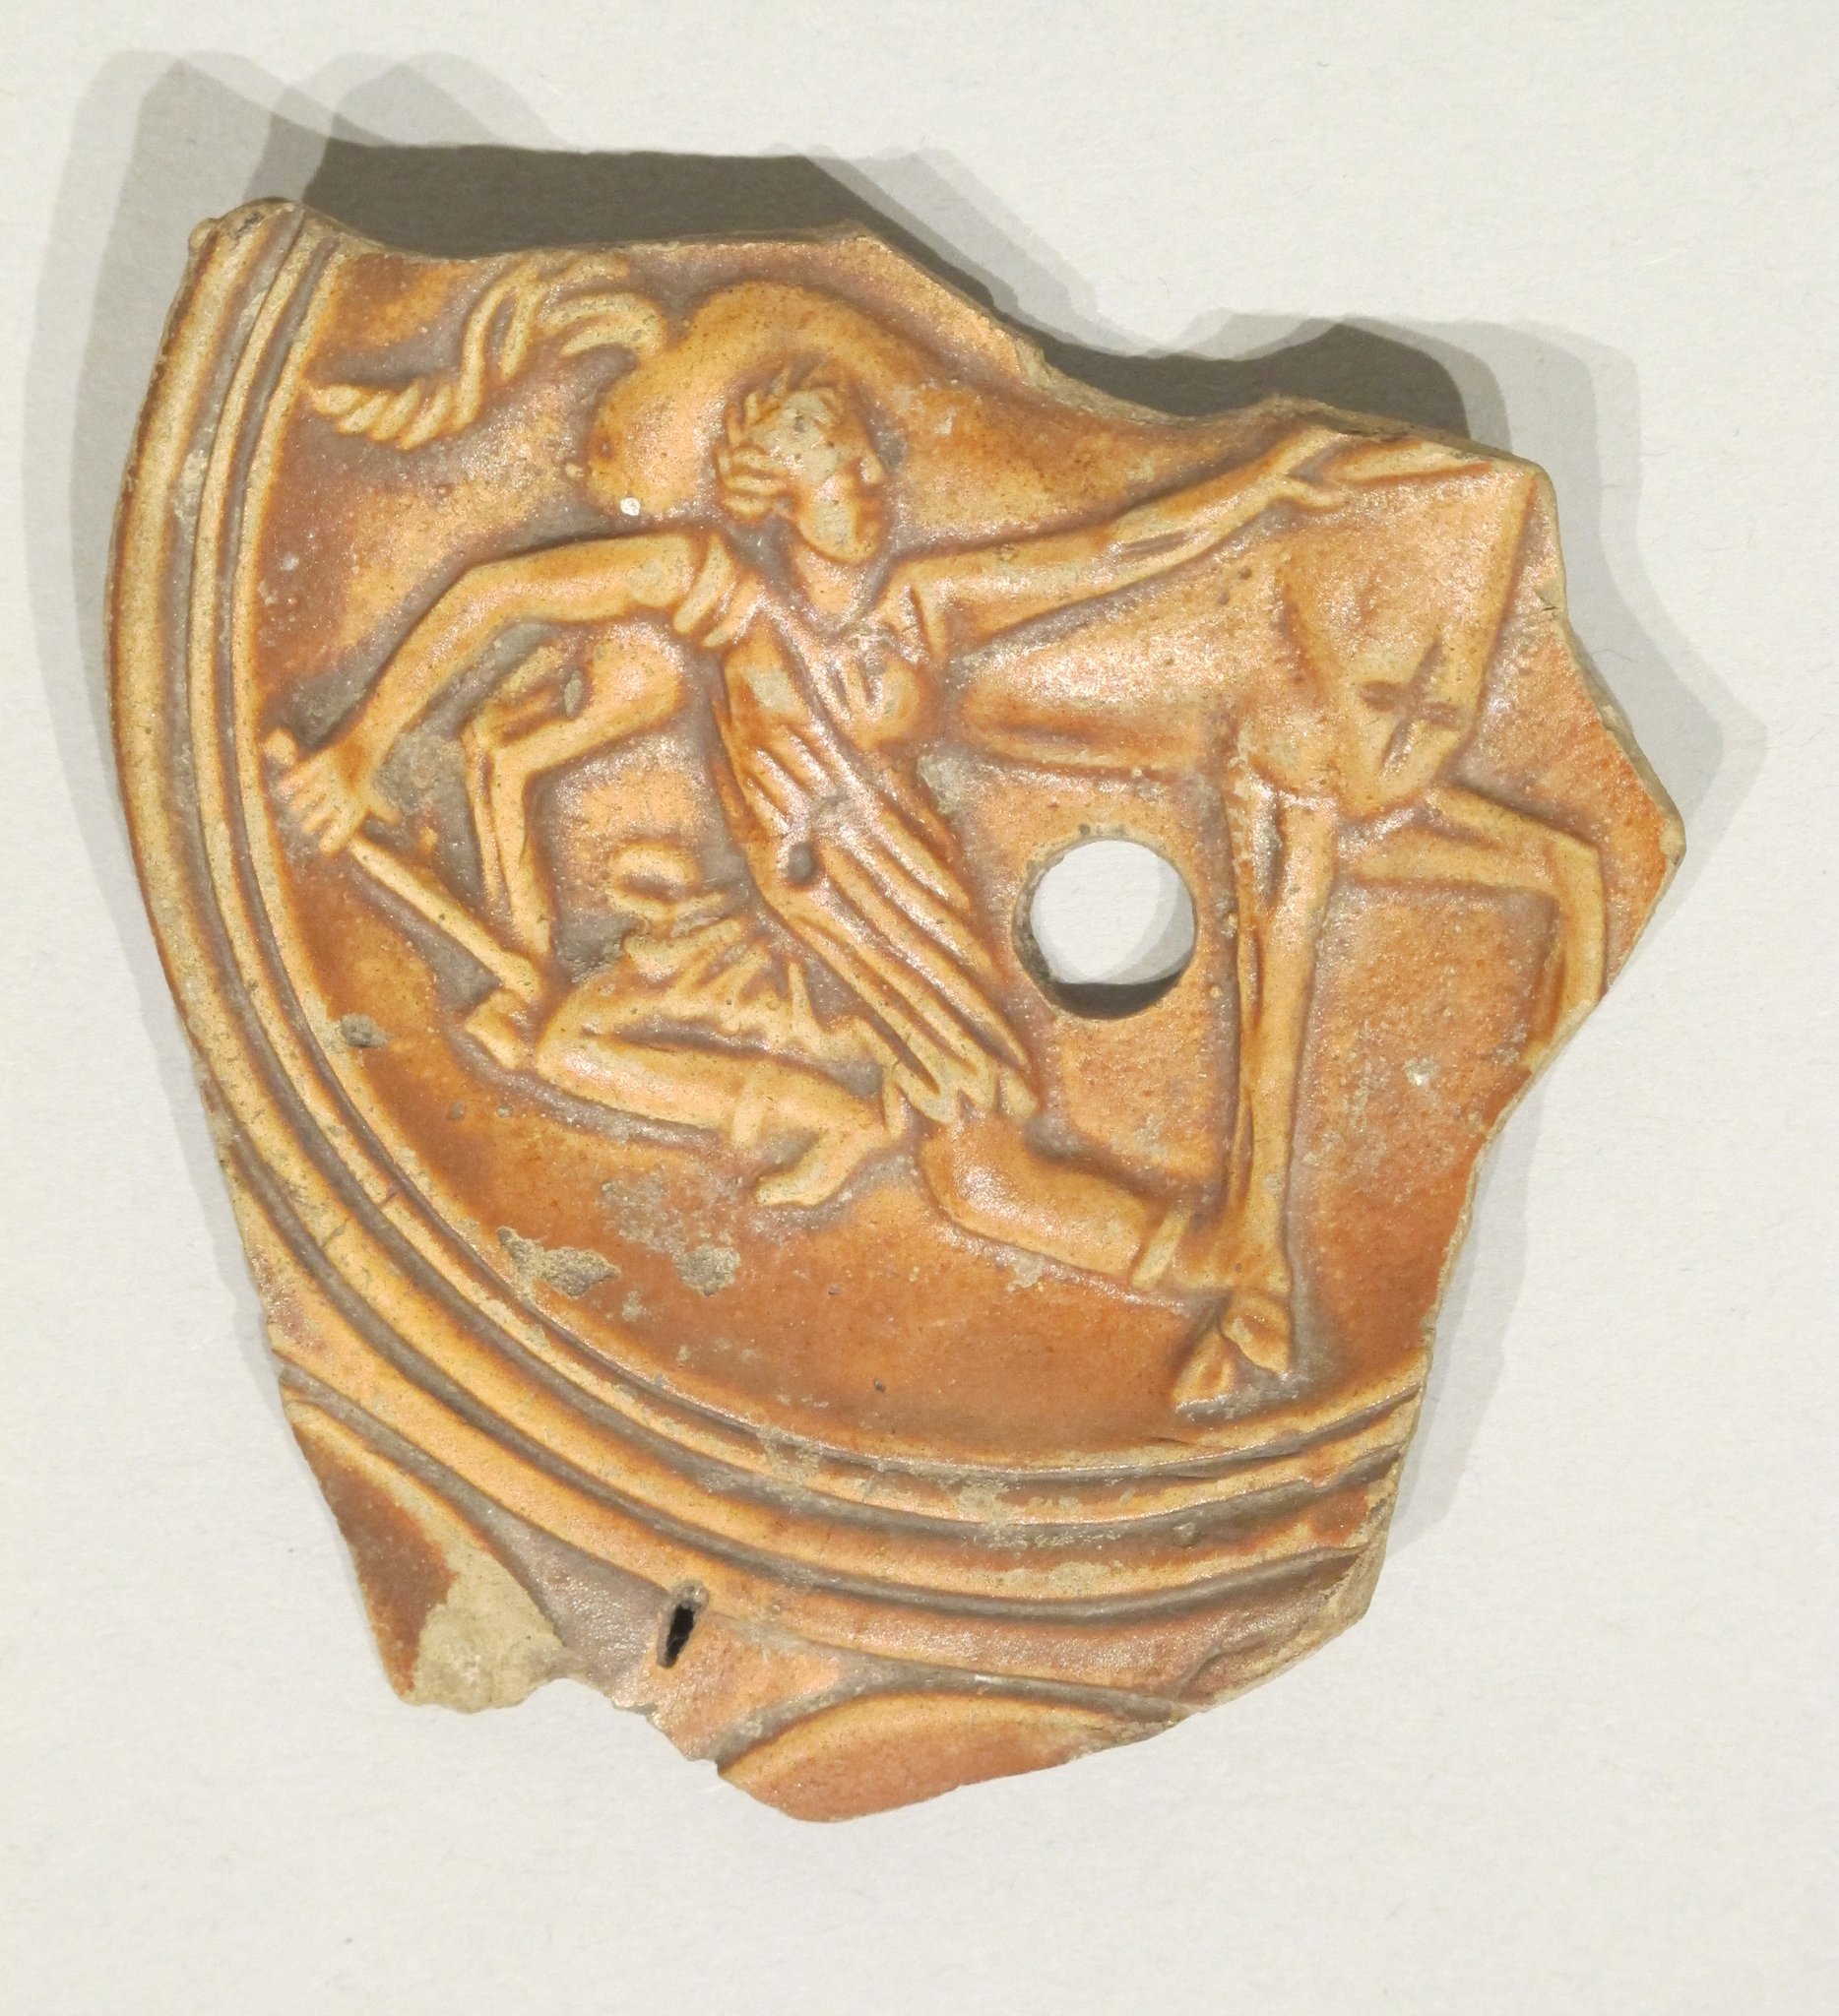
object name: lamp relief fragment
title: Terracotta oil lamp fragment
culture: roman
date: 1-100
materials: terracotta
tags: amazons,horses